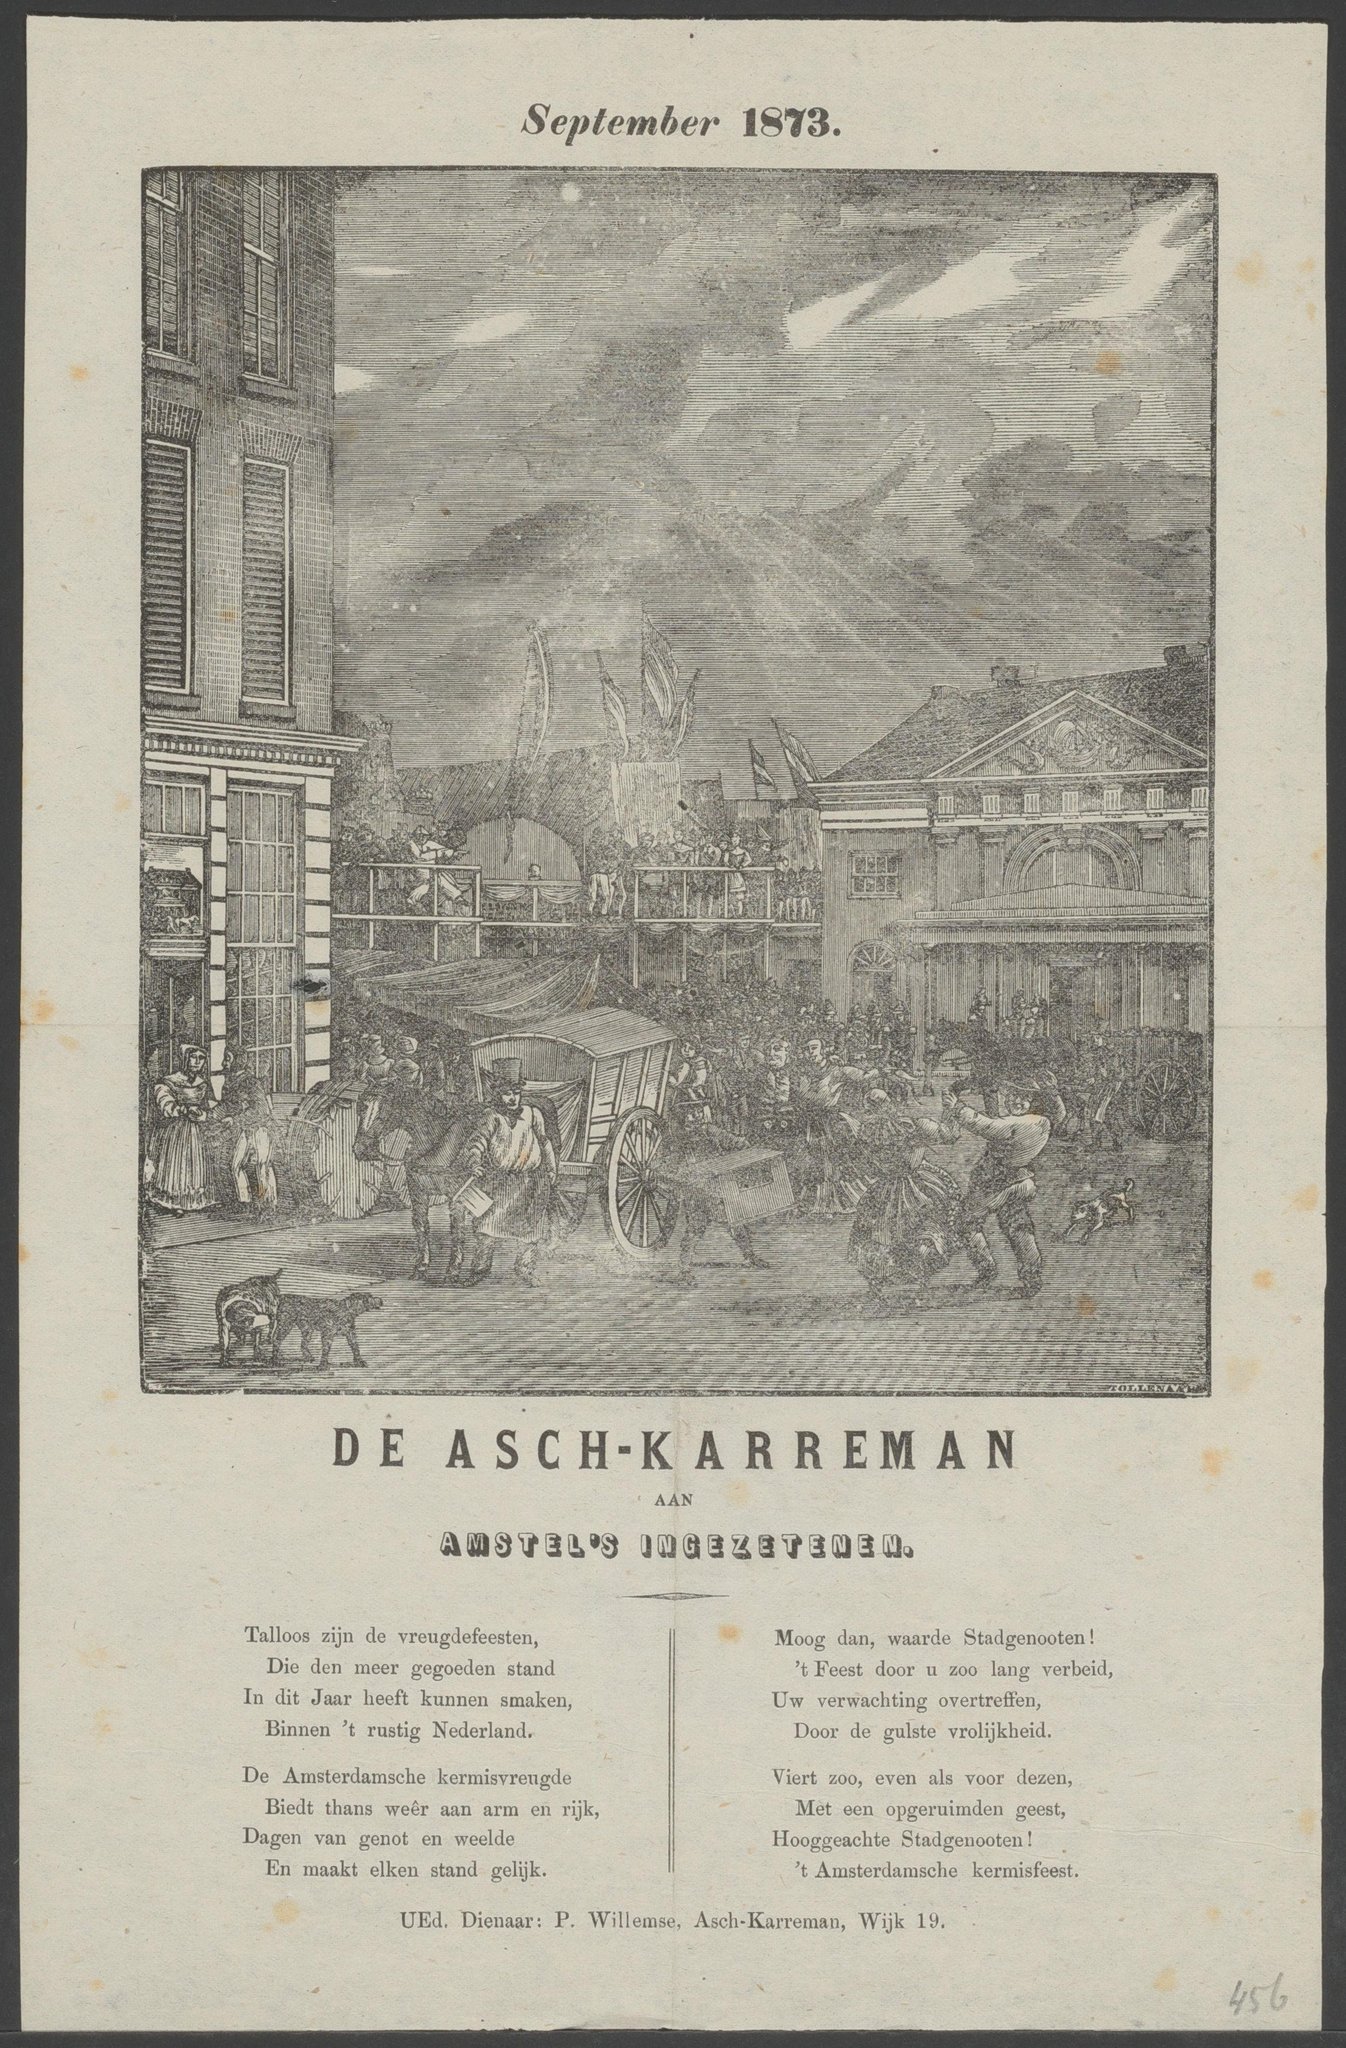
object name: fair print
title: Kermisprent van de Amsterdamse askarrenmannen voor het jaar 1873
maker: dirk wijbrand tollenaar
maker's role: print maker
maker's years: 1808-1858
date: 1873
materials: paper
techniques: letterpress printing, engraving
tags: pleasure fair and circus, garbage collection, amsterdam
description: Kermisprent namens de askarrenmannen (karrenman of vuilnisman) te Amsterdam, september 1873. Gezicht op de kermis op de Botermarkt met de Regulierswaag. Op de markt twee vuilniskarren. Onderaan een gedicht in twee kolommen. Namens P. Willemse, de askarreman van wijk no. 19. Onderwerpsrubrieken binnen de Atlas Zeden en Gewoonten: Zeden en gewoonten in engeren zin, Volksleven, Volksbladen, Nieuwjaars- en Kerstwenschen, Amsterdam.